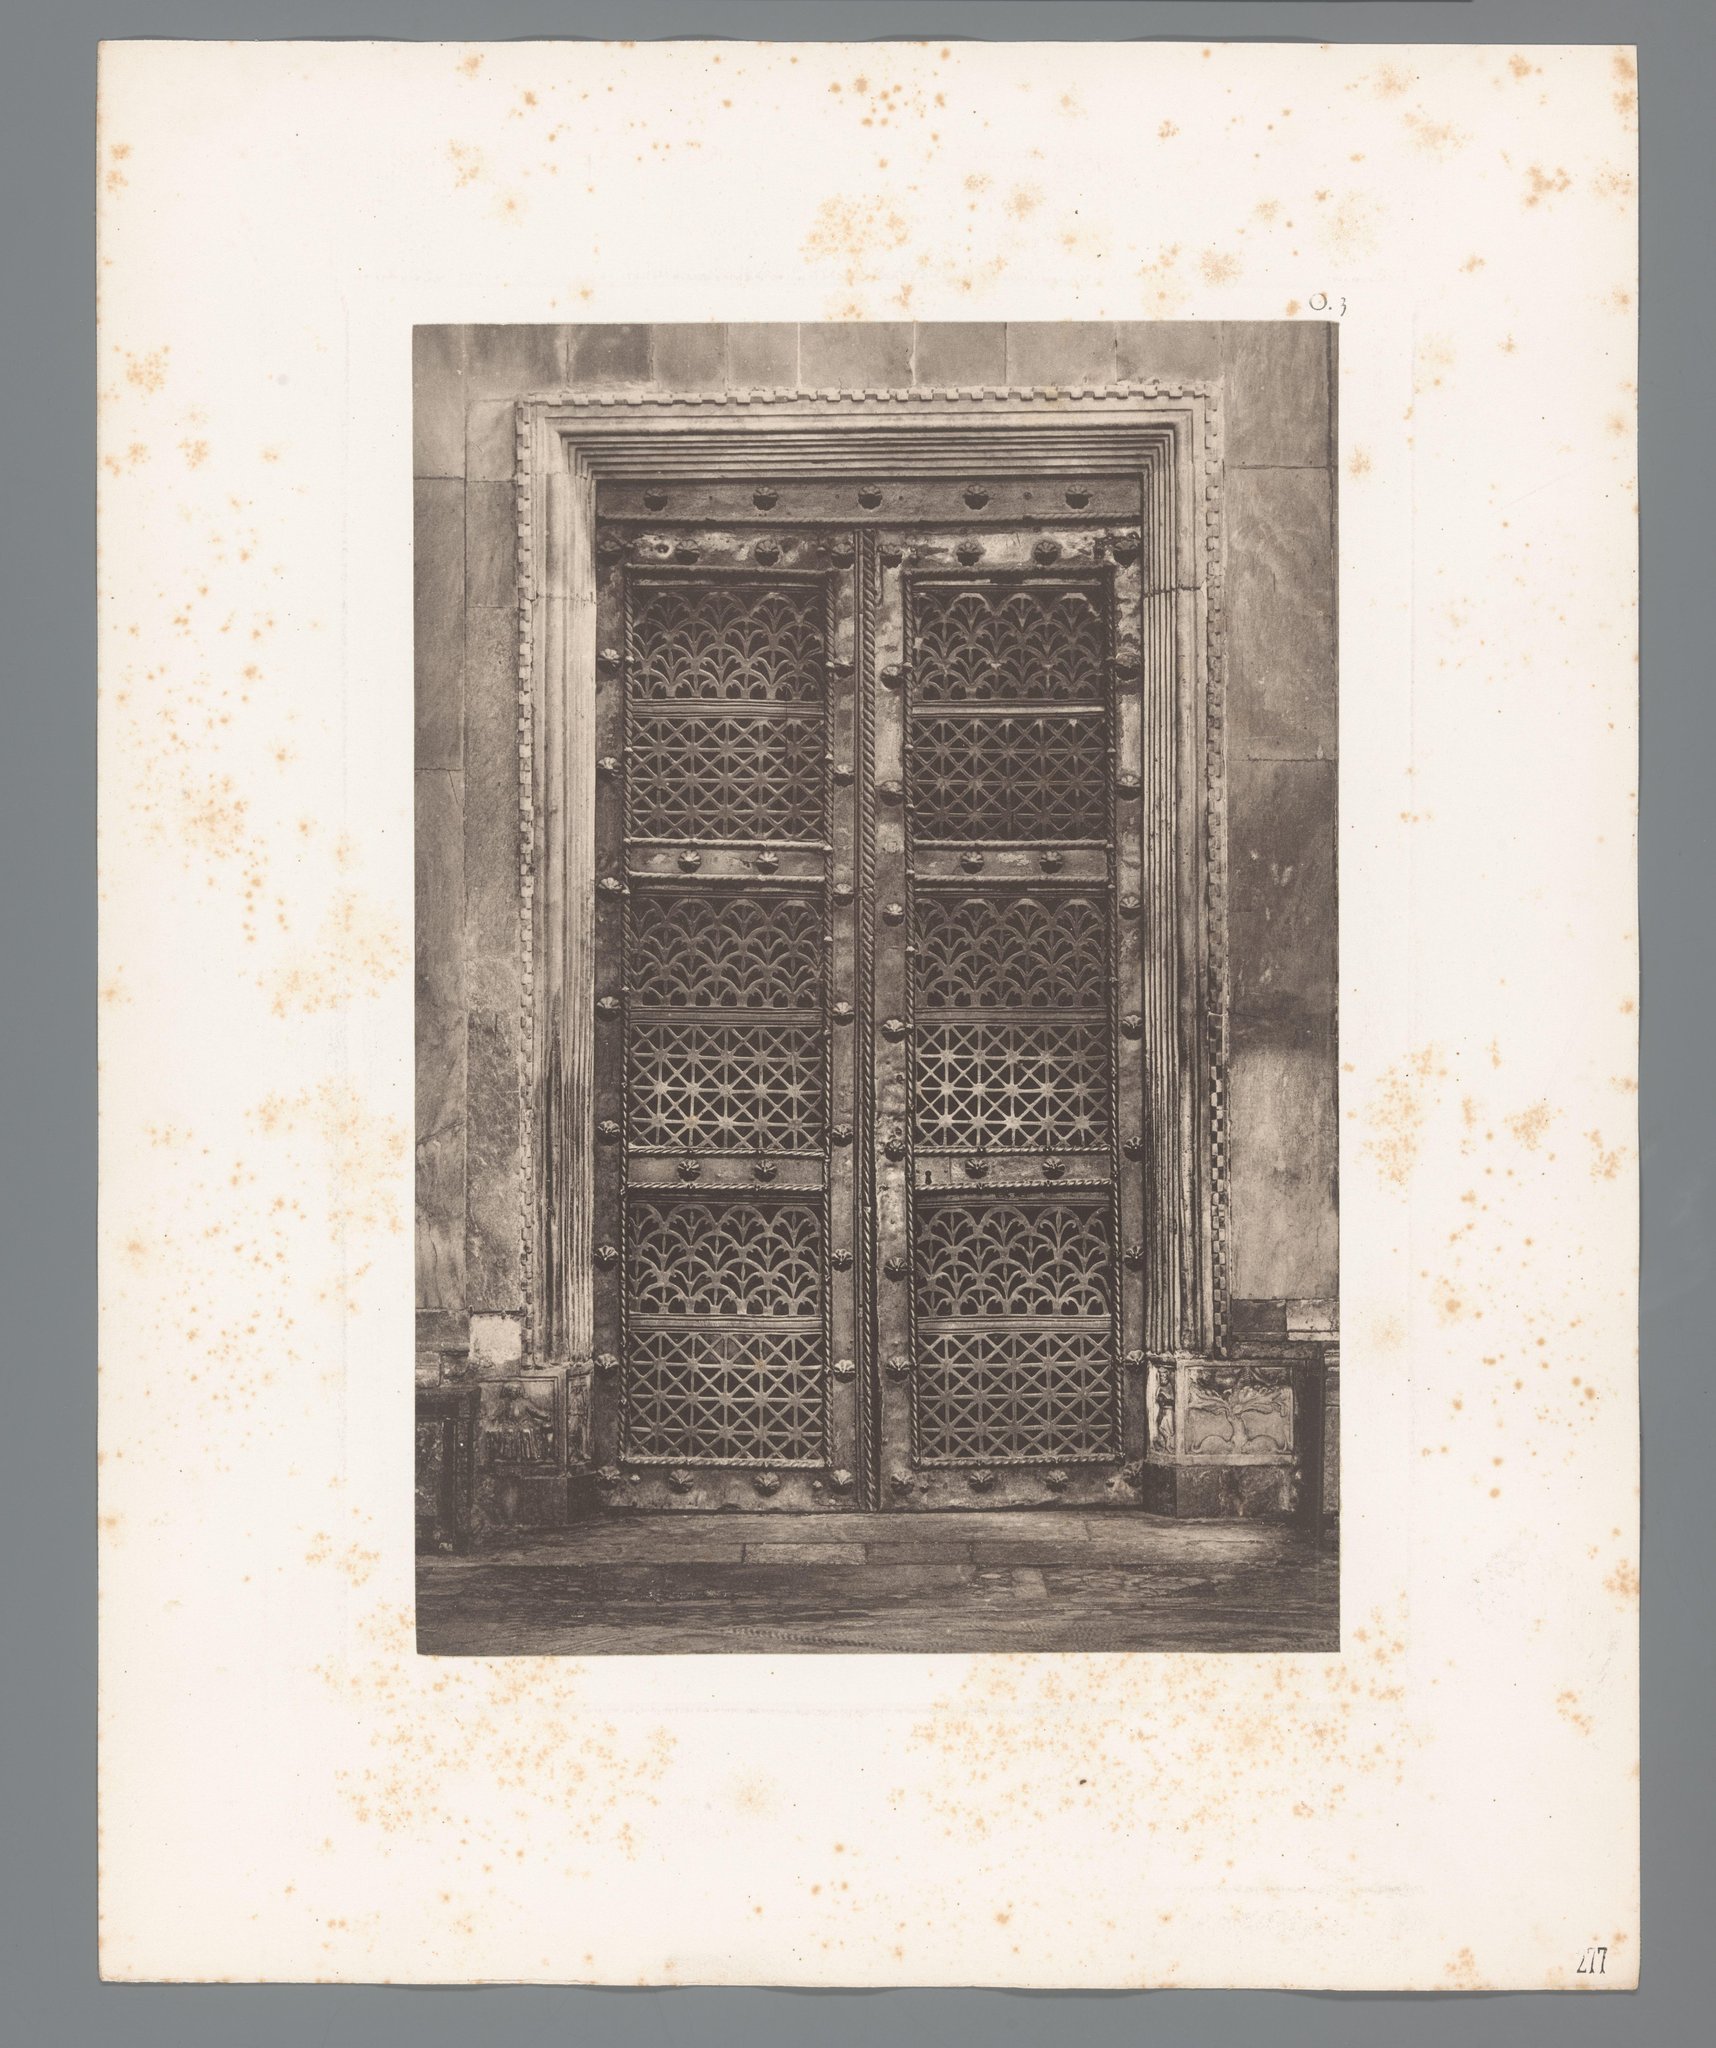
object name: photomechanical print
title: Bronzen deur van de San Marco in Venetië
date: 1880-1885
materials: paper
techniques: photograph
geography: venice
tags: church (exterior), closed door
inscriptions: number: ‘277’, number: ‘O.3’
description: Deze prent maakt deel uit van een omslag met 58 prenten op 50 bladen.